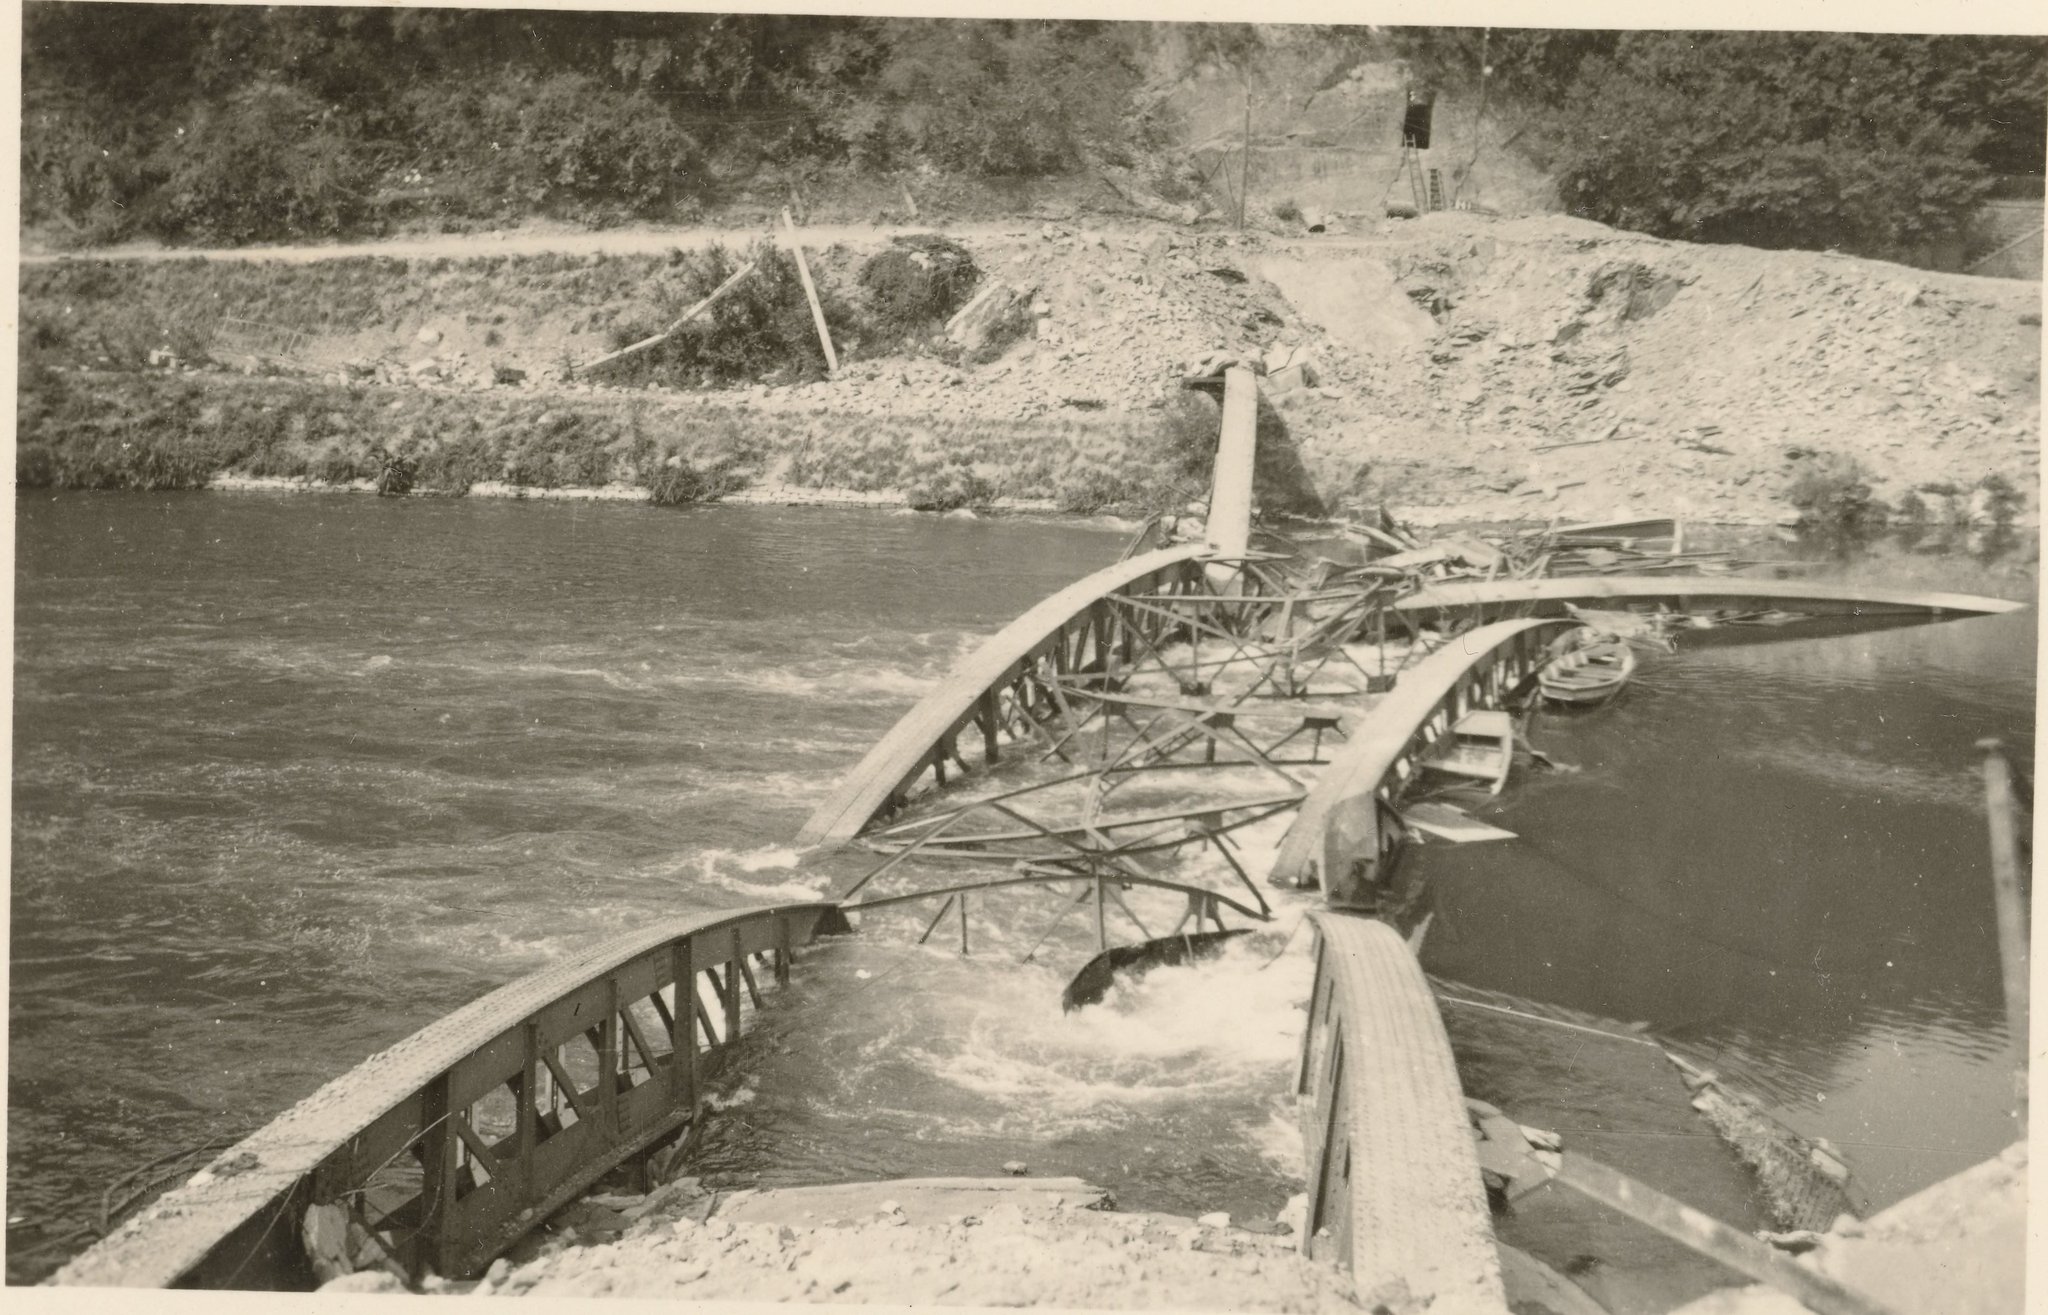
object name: photograph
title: Verwoeste brug over een rivier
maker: Anonymous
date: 1940-1945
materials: photographic support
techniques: gelatin silver print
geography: germany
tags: netherlands, germany, france, belgium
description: Opgeblazen brug over een rivier. Foto behorend bij album 'Kriegserinnerungen'.